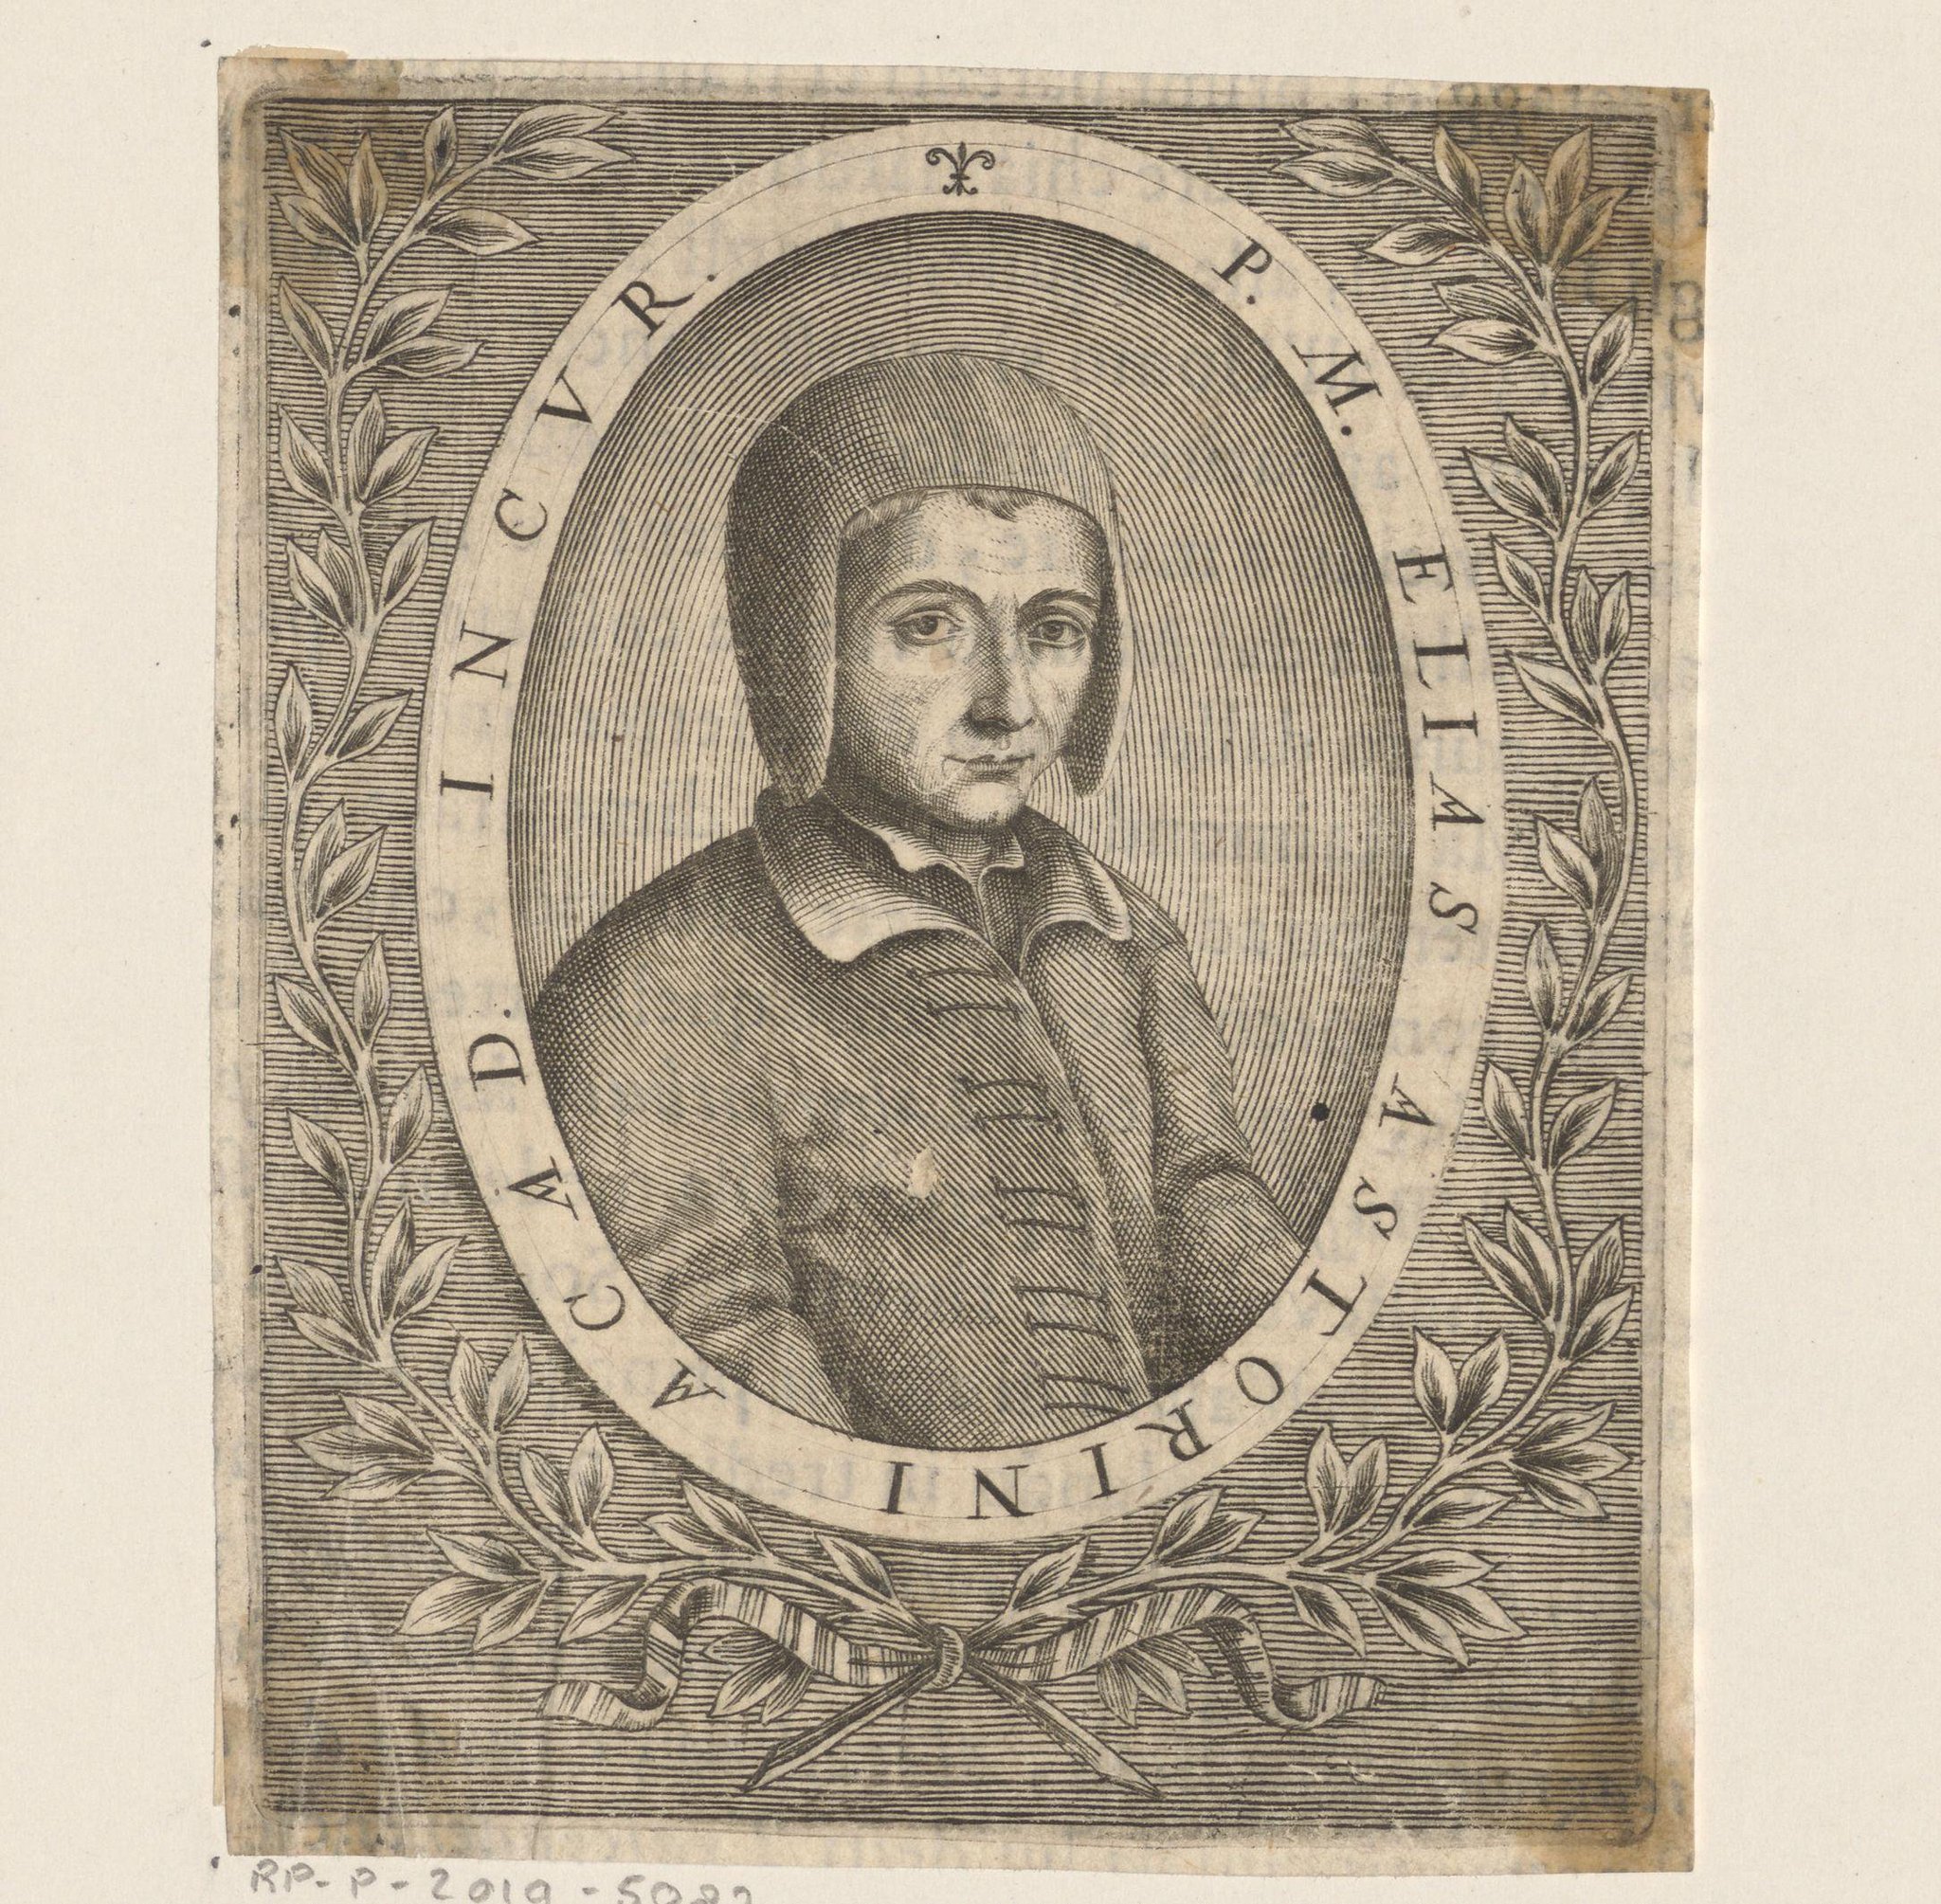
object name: print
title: Portret van Elia Astorini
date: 1703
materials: paper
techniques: engraving, etching, letterpress printing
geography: naples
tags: historical persons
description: Prent uit: Gimma, Giacinto. Elogj accademici della Società degli Spensierati di Rossano (...). Napels: Carlo Troise, 1703, p. 387.